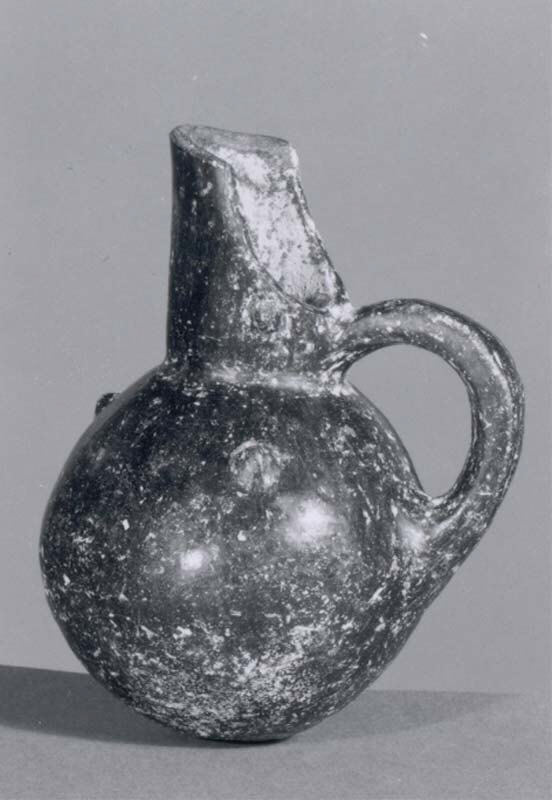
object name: jug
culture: yortan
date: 2700-2400 BCE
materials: ceramic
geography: northwestern anatolia